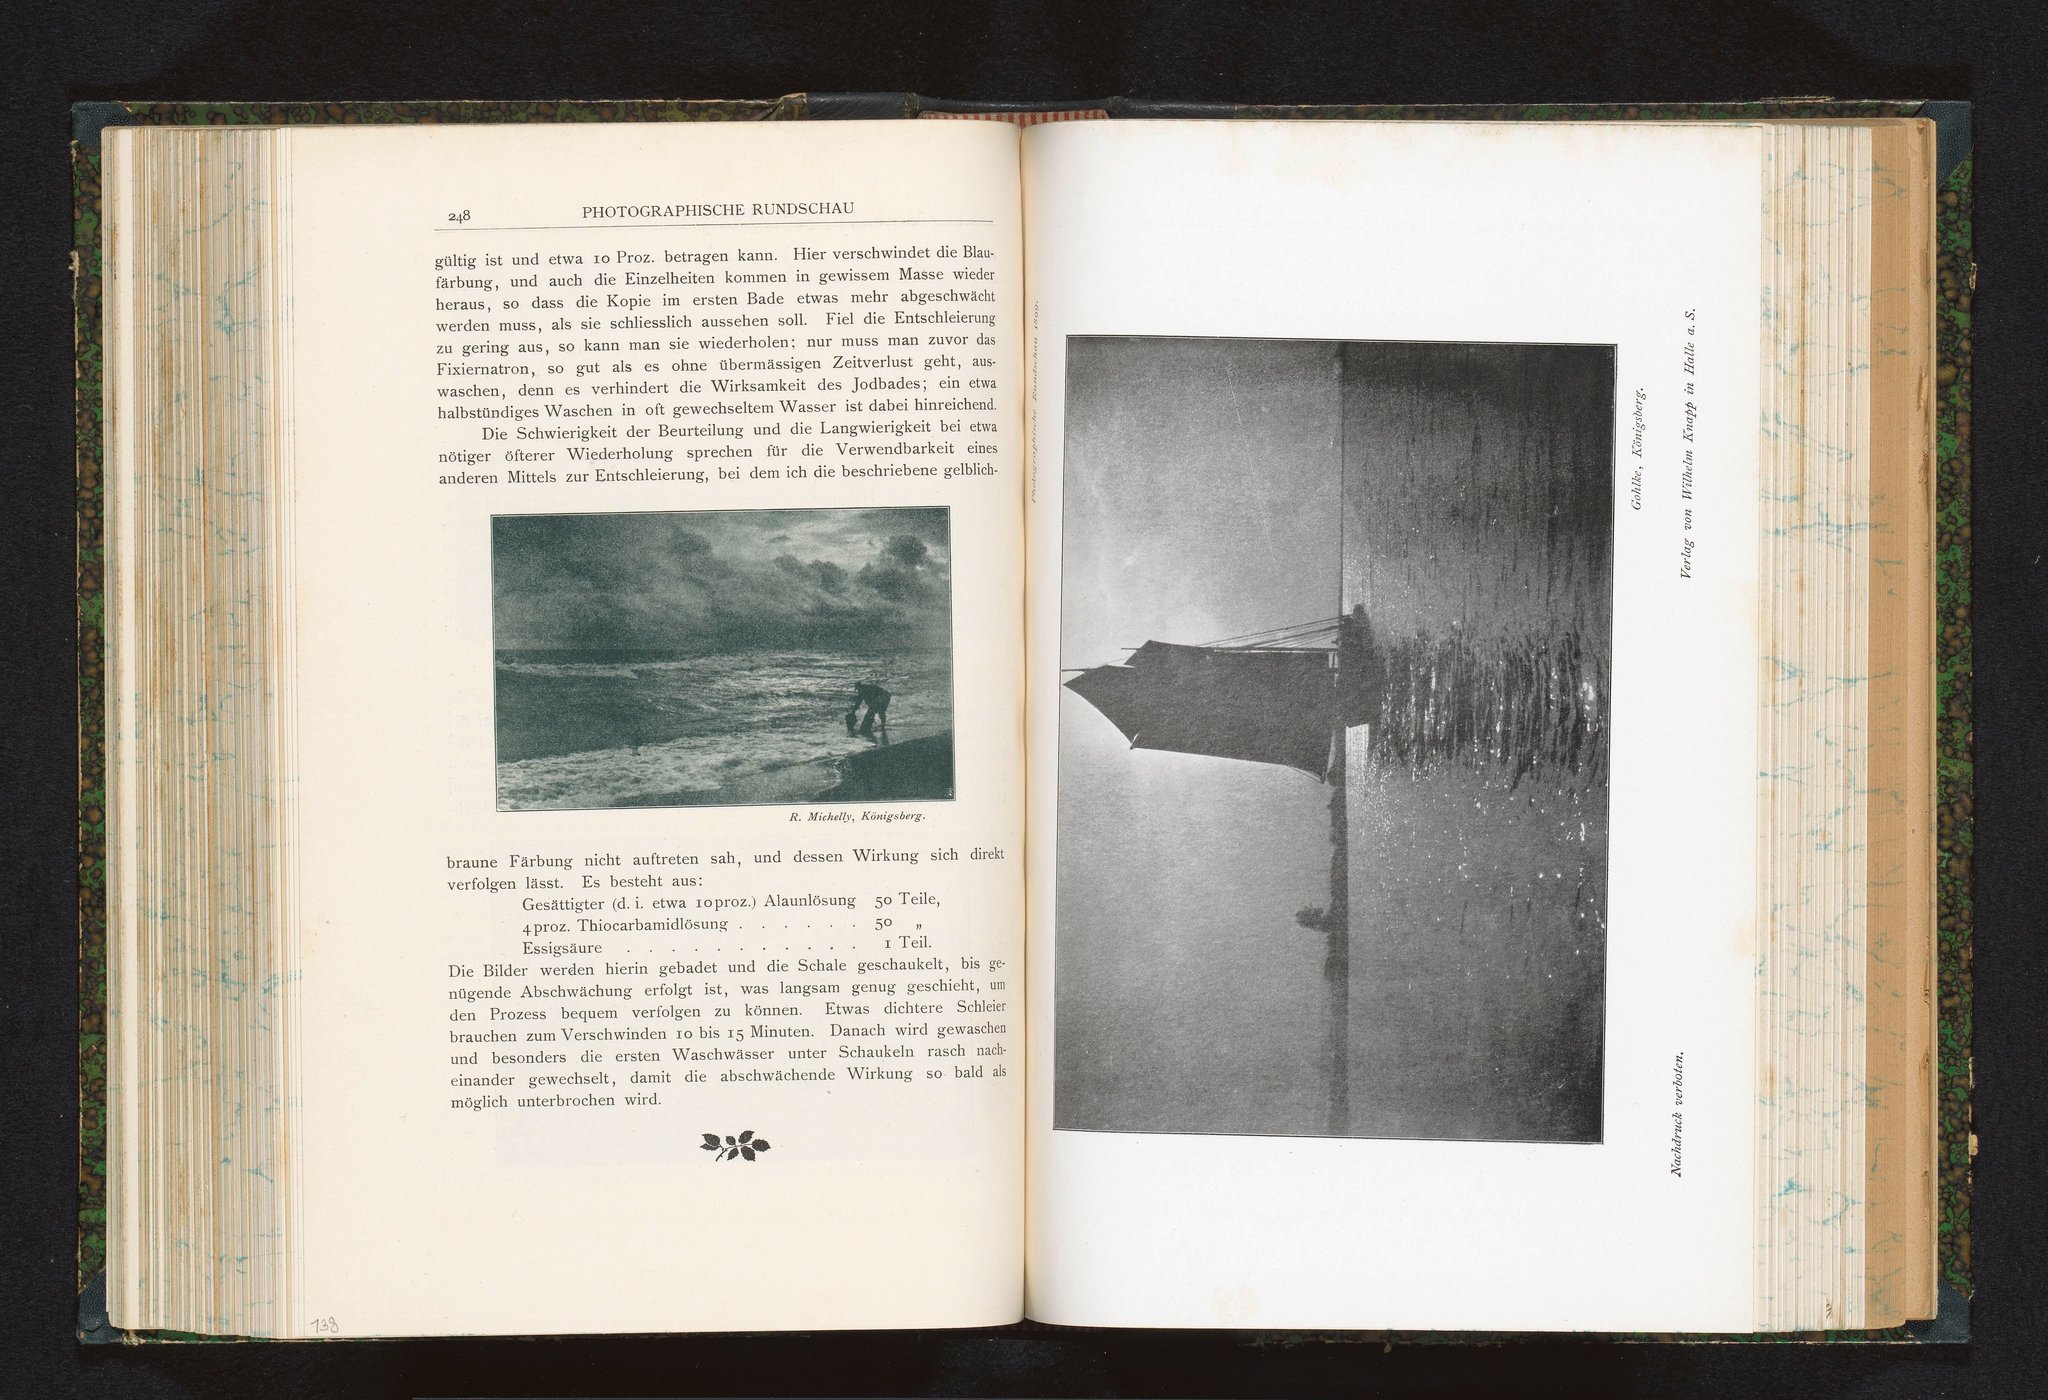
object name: page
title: Zeilboot op het water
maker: gohlke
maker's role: fotograaf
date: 1894-1899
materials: paper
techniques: autotype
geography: berlin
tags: sailing-ship, sailing-boat, sea (seascape)